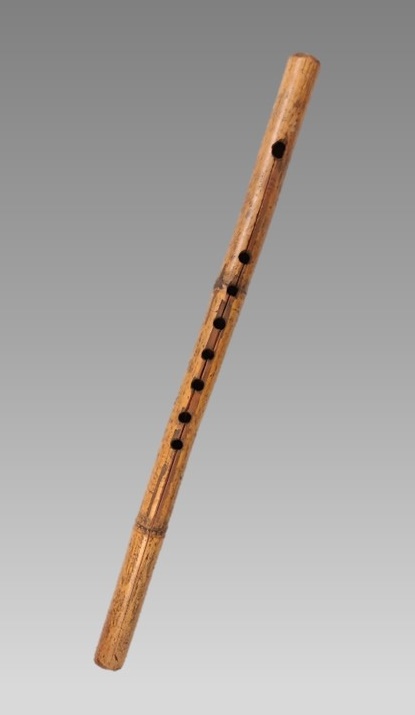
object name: transverse flute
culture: melanesian, bismarck archipelago or papua new guinean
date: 1867-1900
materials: bamboo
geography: papua new guinea